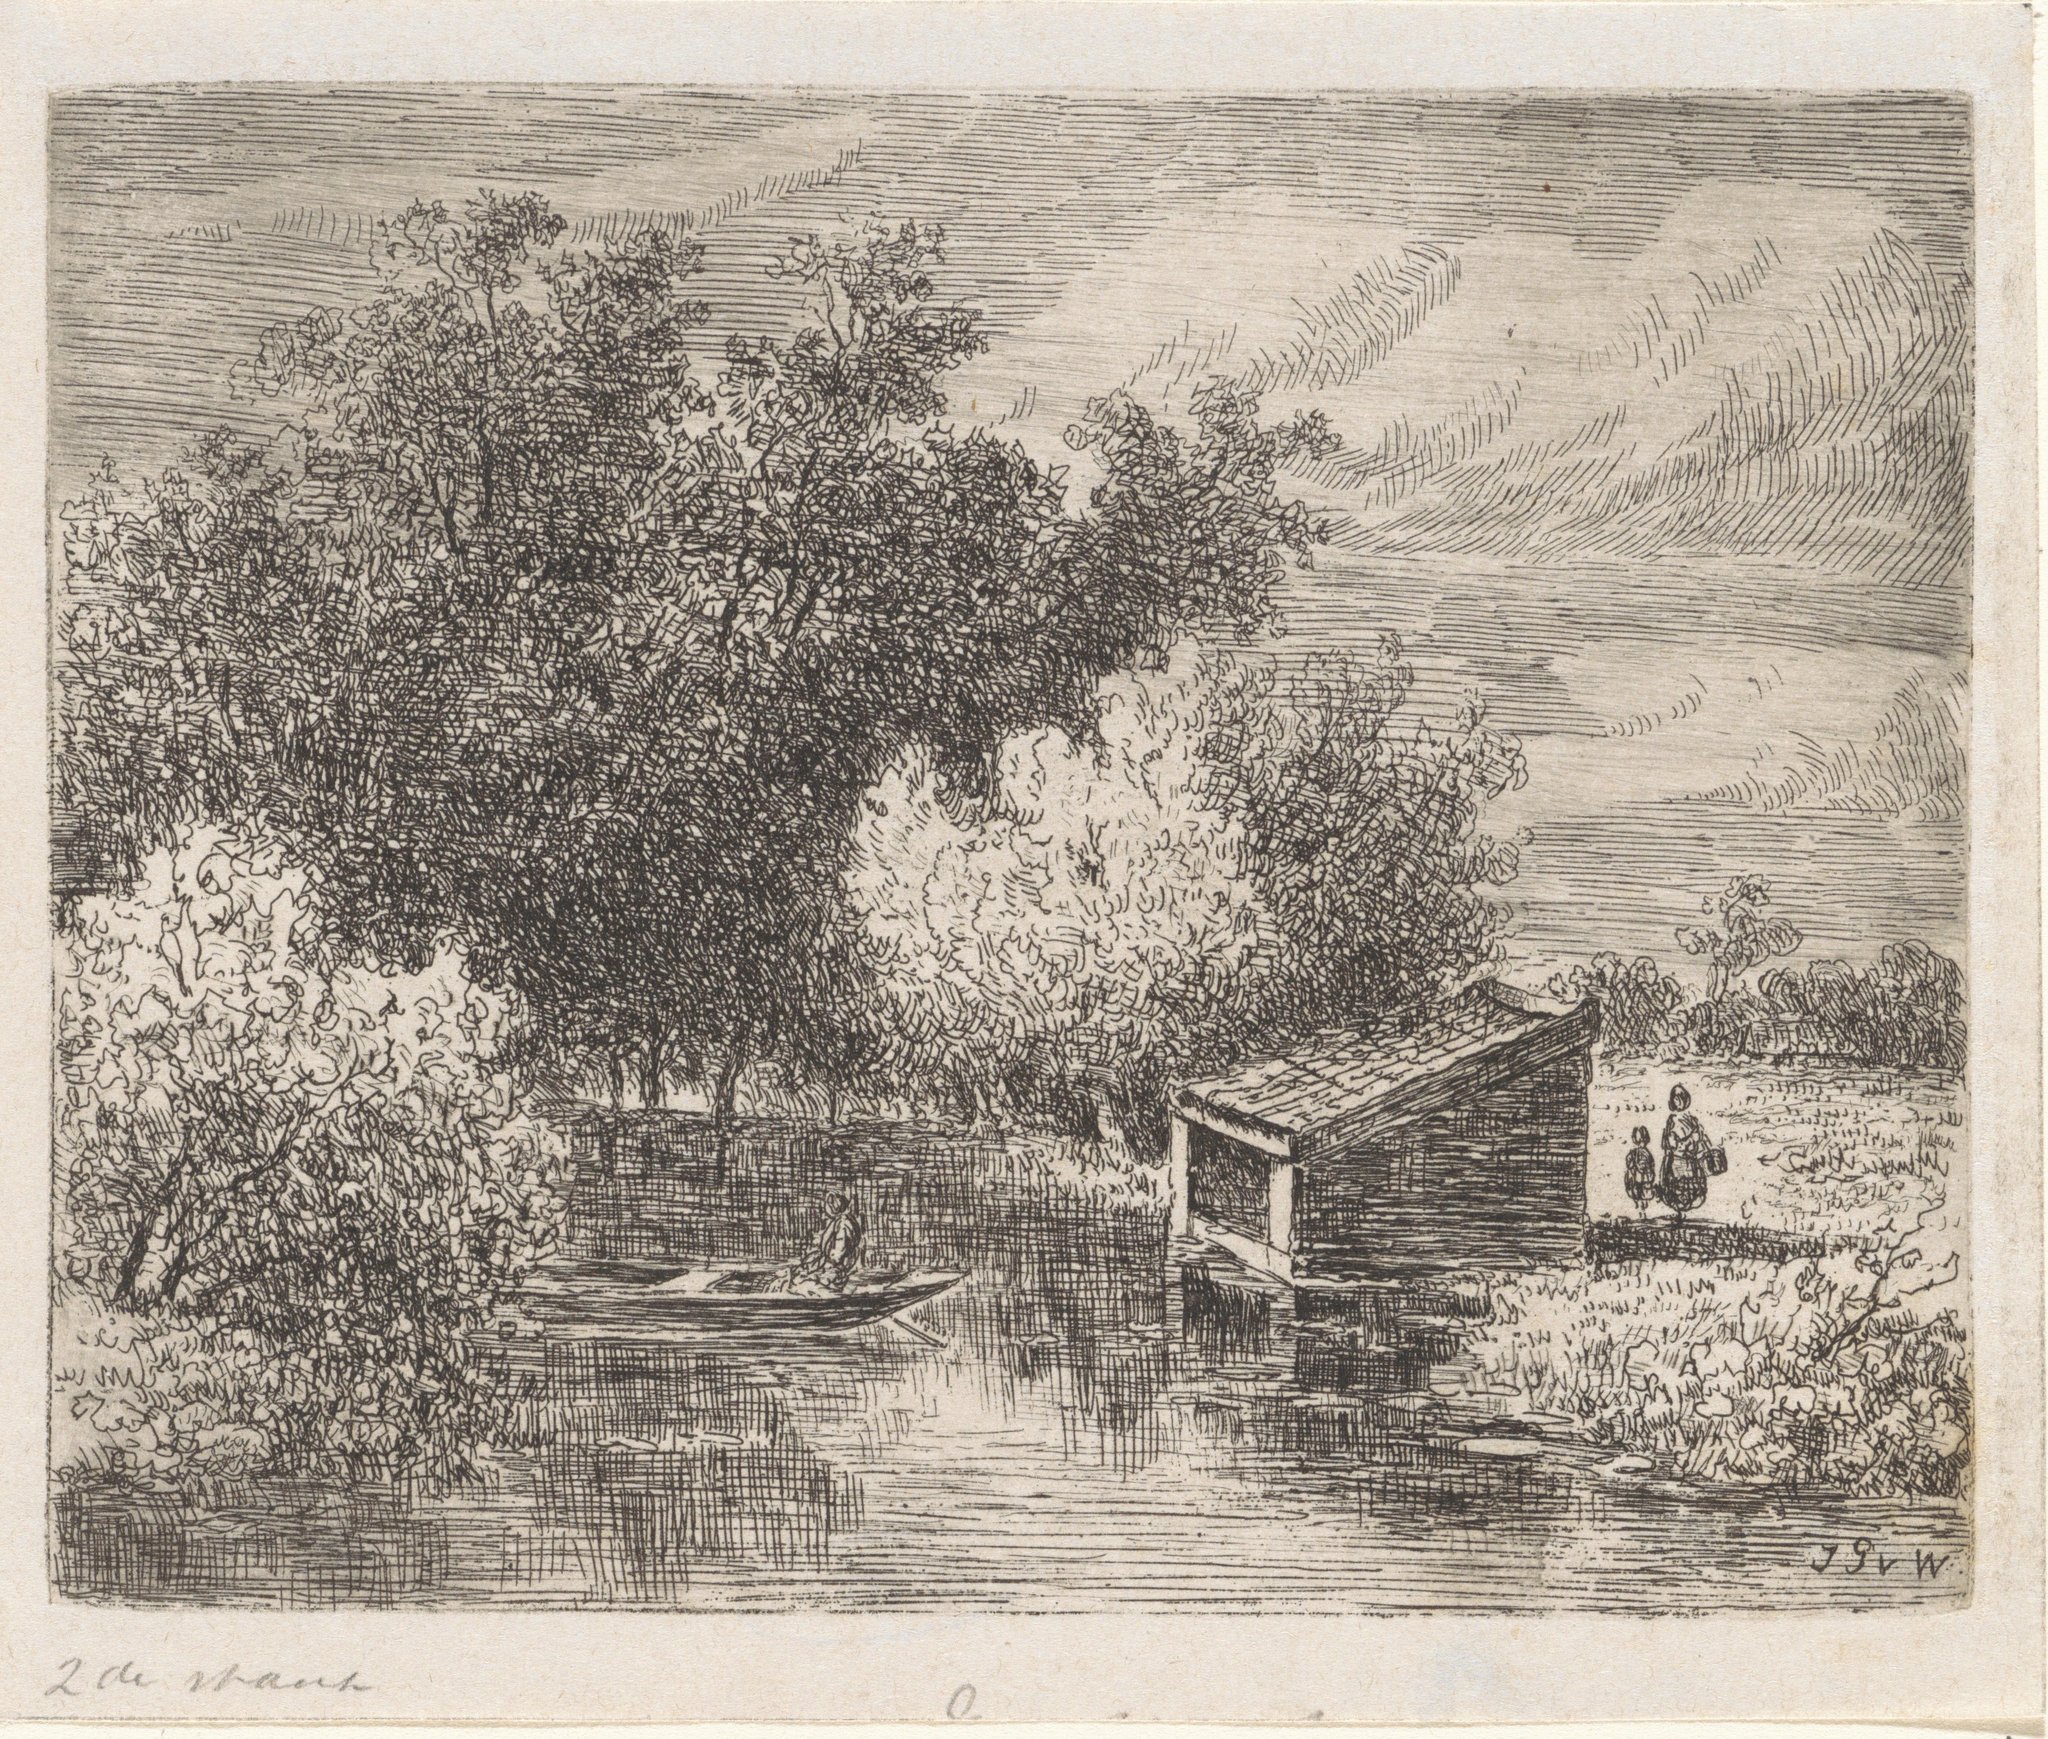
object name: print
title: Boothuis aan een rivier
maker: johannes pieter van wisselingh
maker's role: draughtsman, painter, print maker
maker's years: 1812-1899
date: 1830-1878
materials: paper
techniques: etching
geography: netherlands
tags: river, rowing-boat, canoe, etc., boat-house, shed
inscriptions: collector's mark: Lugt 2228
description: Rechts een boothuis aan een rivier. Op de rivier zit een man in een roeiboot. Achter het boothuis loopt een vrouw met een kind.